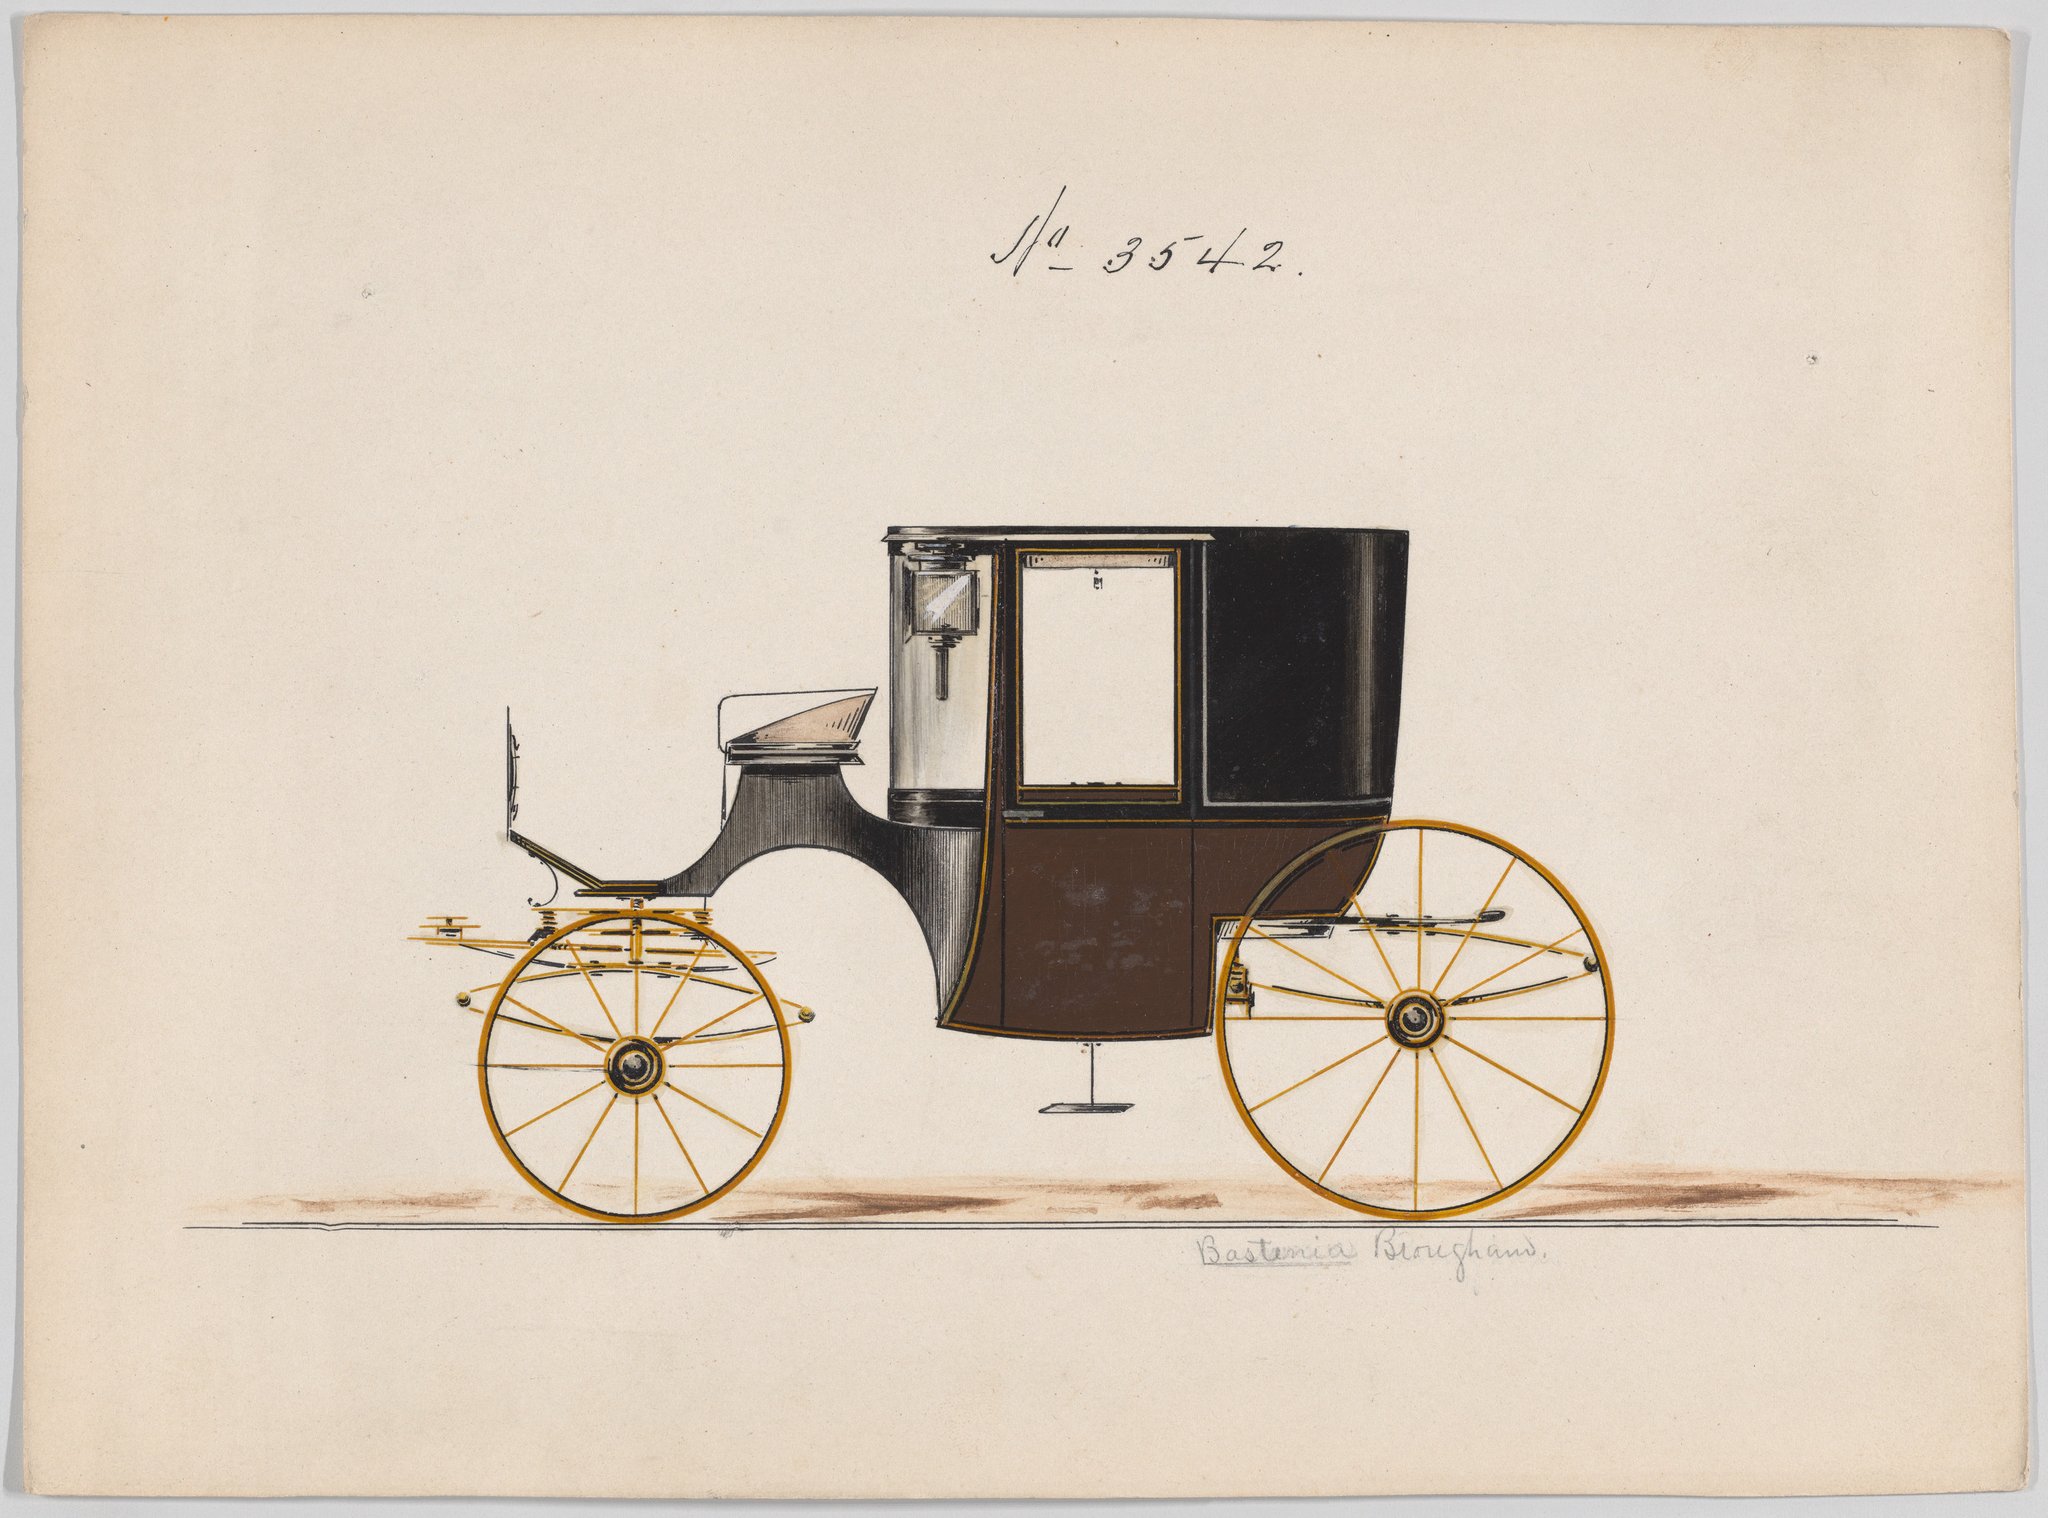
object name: drawing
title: Design for Coupé, no. 3542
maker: brewster & co.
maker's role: manufacturer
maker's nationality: american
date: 1879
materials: gouache, gum arabic, ink, watercolor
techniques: pen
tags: carriages